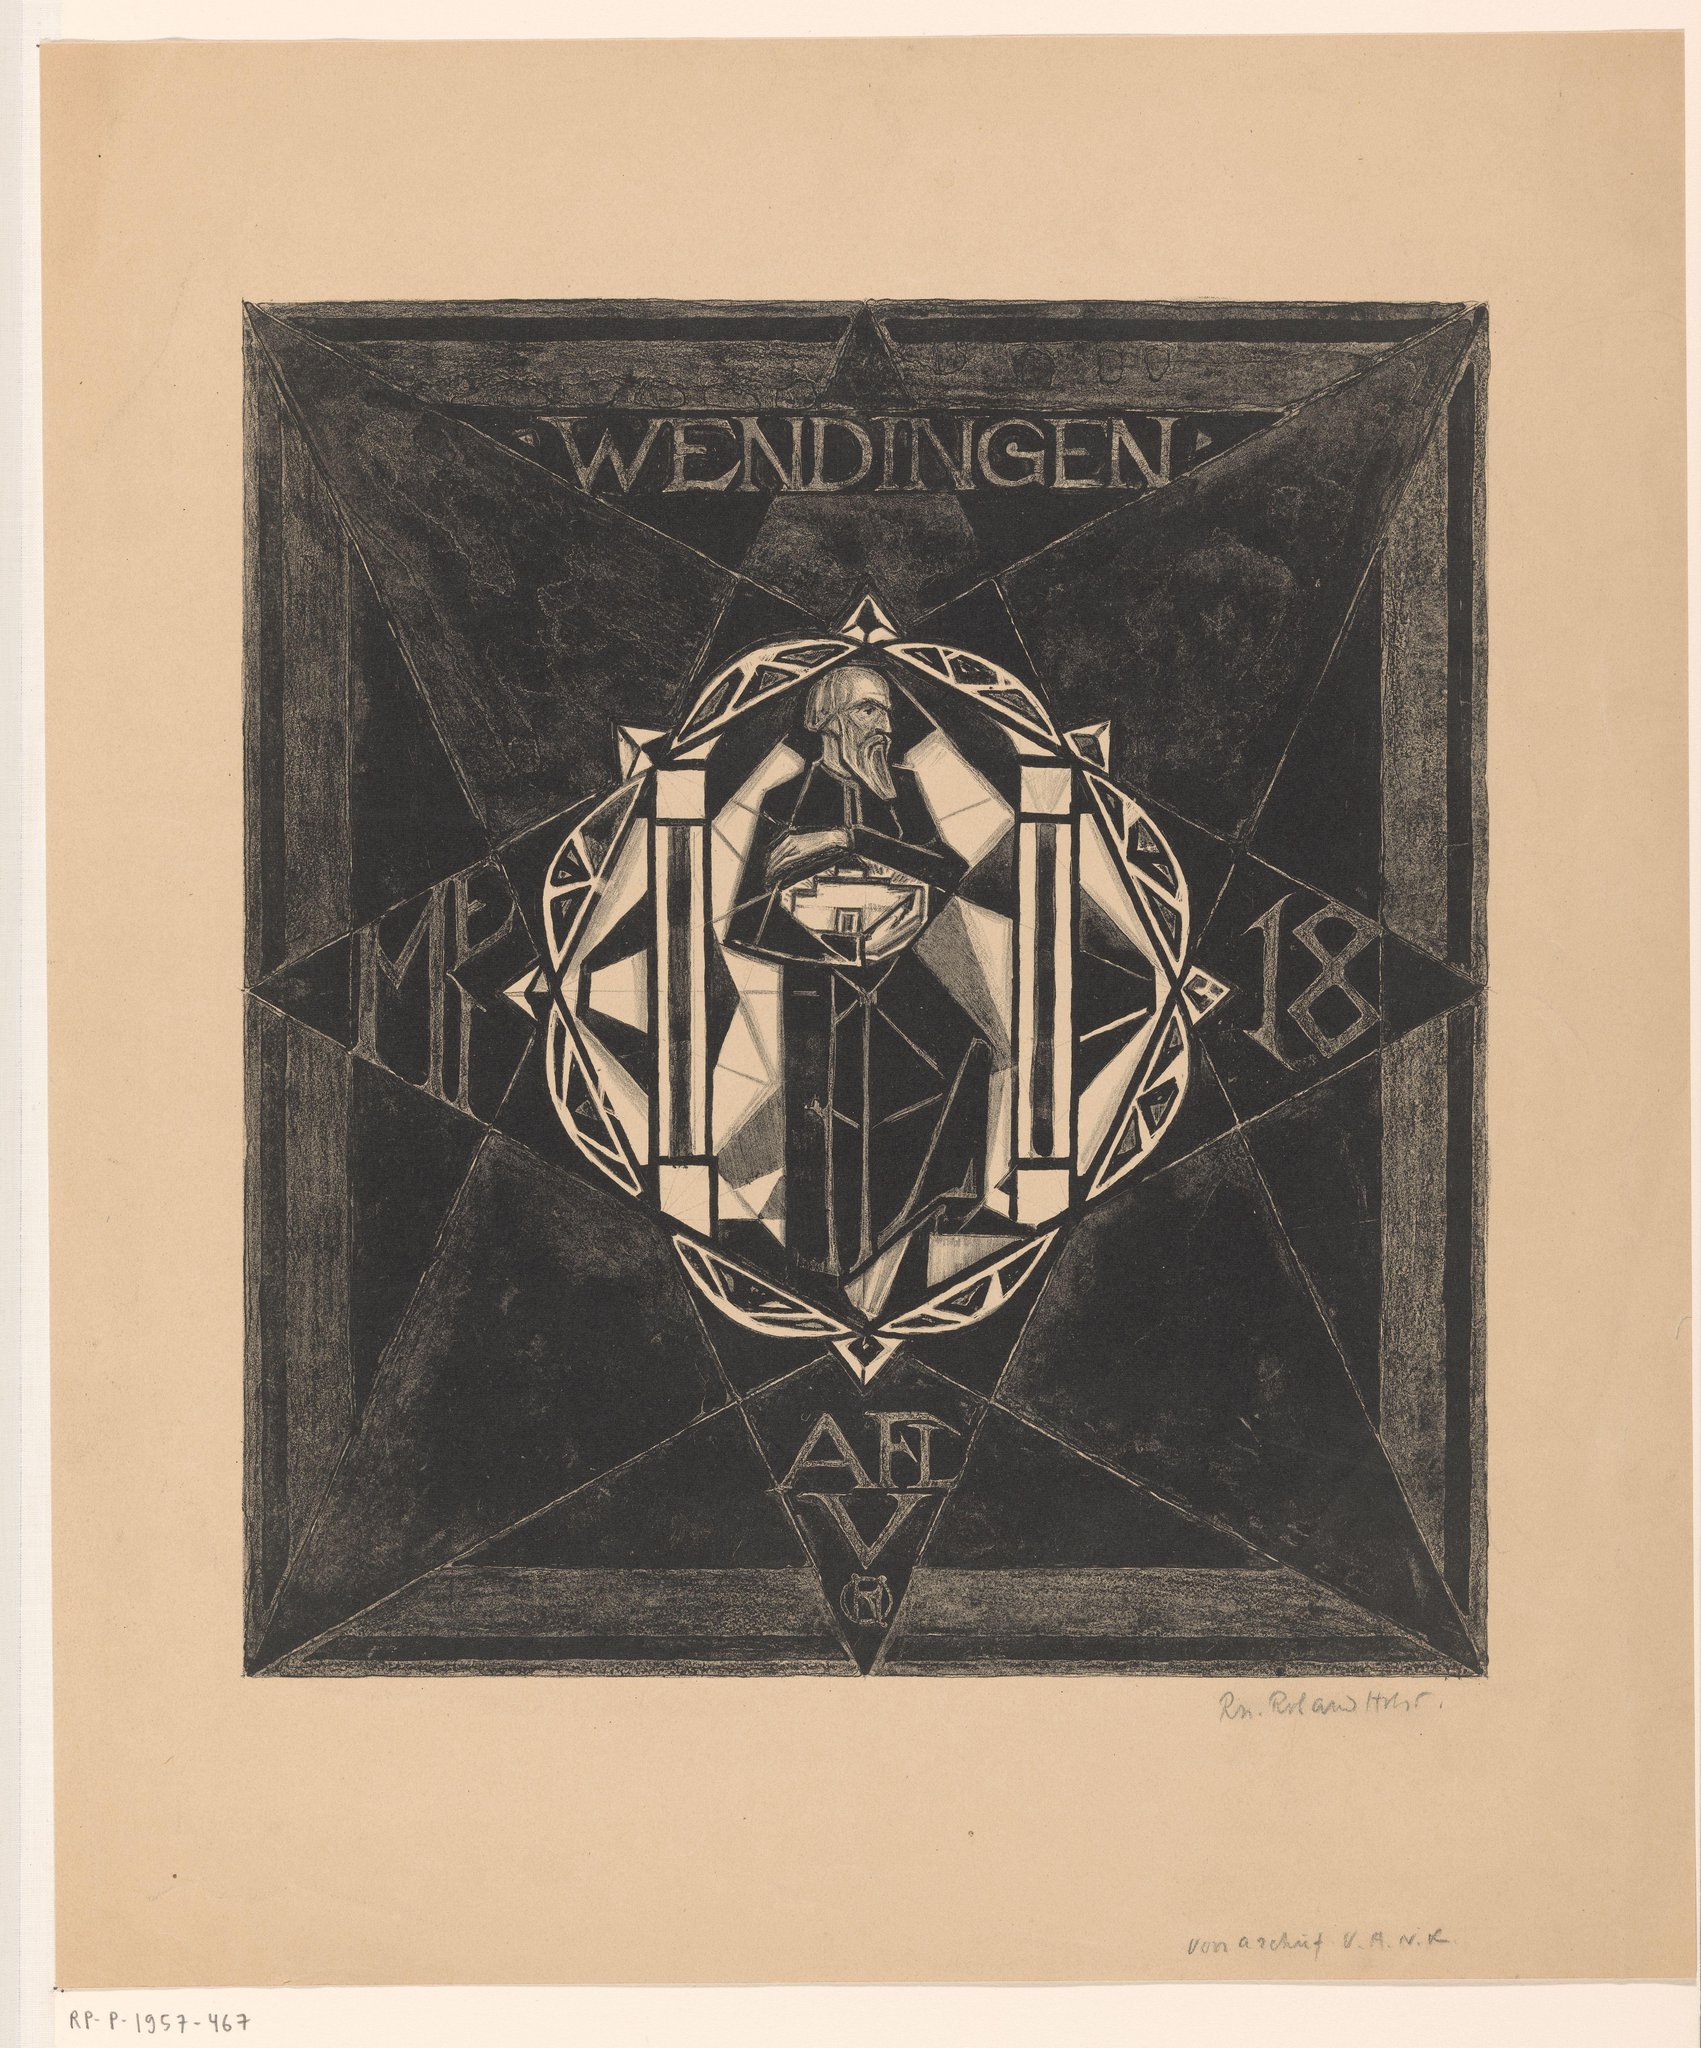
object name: print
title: Omslagontwerp voor: Wendingen, 1918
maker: richard nicolaüs roland holst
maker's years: 1868-1938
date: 1918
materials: paper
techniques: lithograph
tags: crystals, column, pillar ~ architecture, architect in non-work situation, architectural design or model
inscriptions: collector's mark: Lugt 2228, inscription: ‘voor archief V.A.N.R.’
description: Een bebaarde man, mogelijk Hiram, de architect van de Tempel van Salomo in Jeruzalem, houdt een model van een tempel vast. Hij staat tussen twee pilaren in het midden van een kristal.